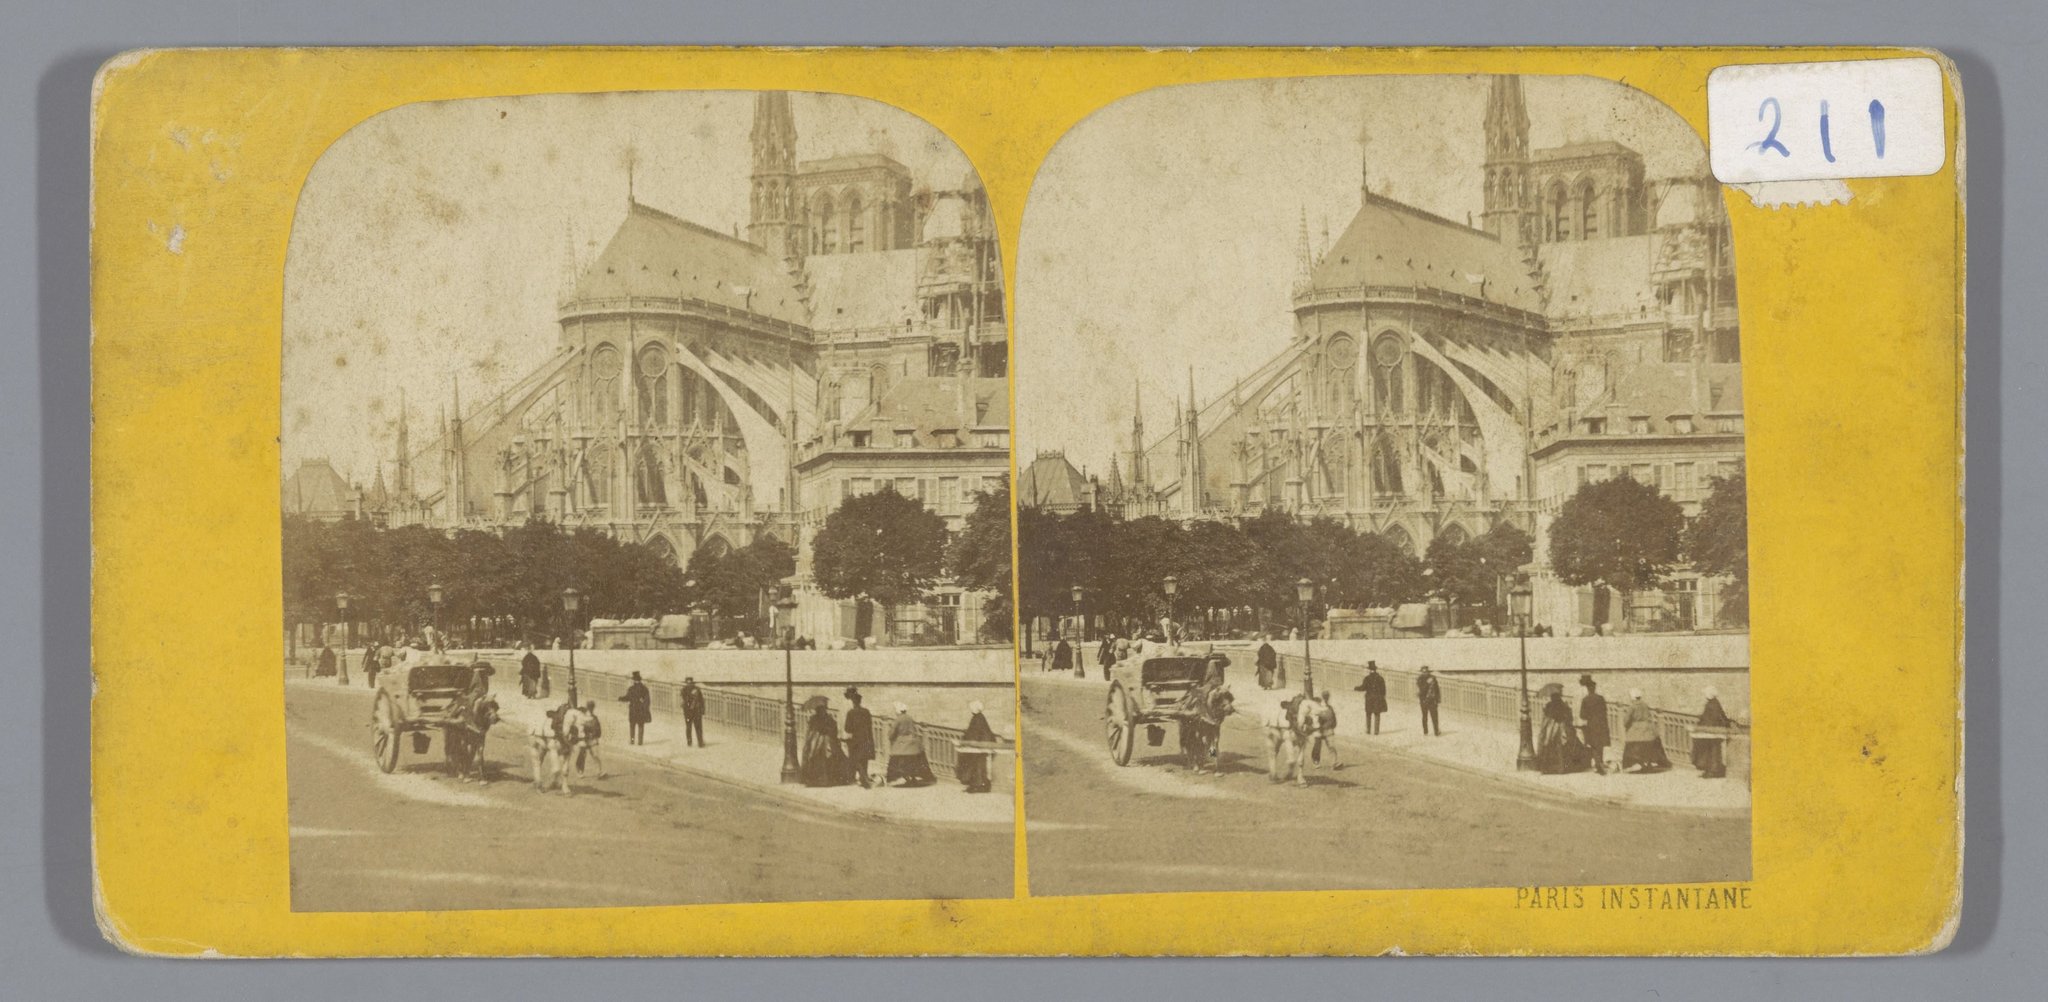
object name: stereograph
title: Notre Dame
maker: Anonymous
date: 1868-1890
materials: cardboard, paper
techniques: albumen print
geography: paris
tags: church (exterior), bridge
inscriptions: number: ‘211’, inscription: ‘Paris: Notre Dame’